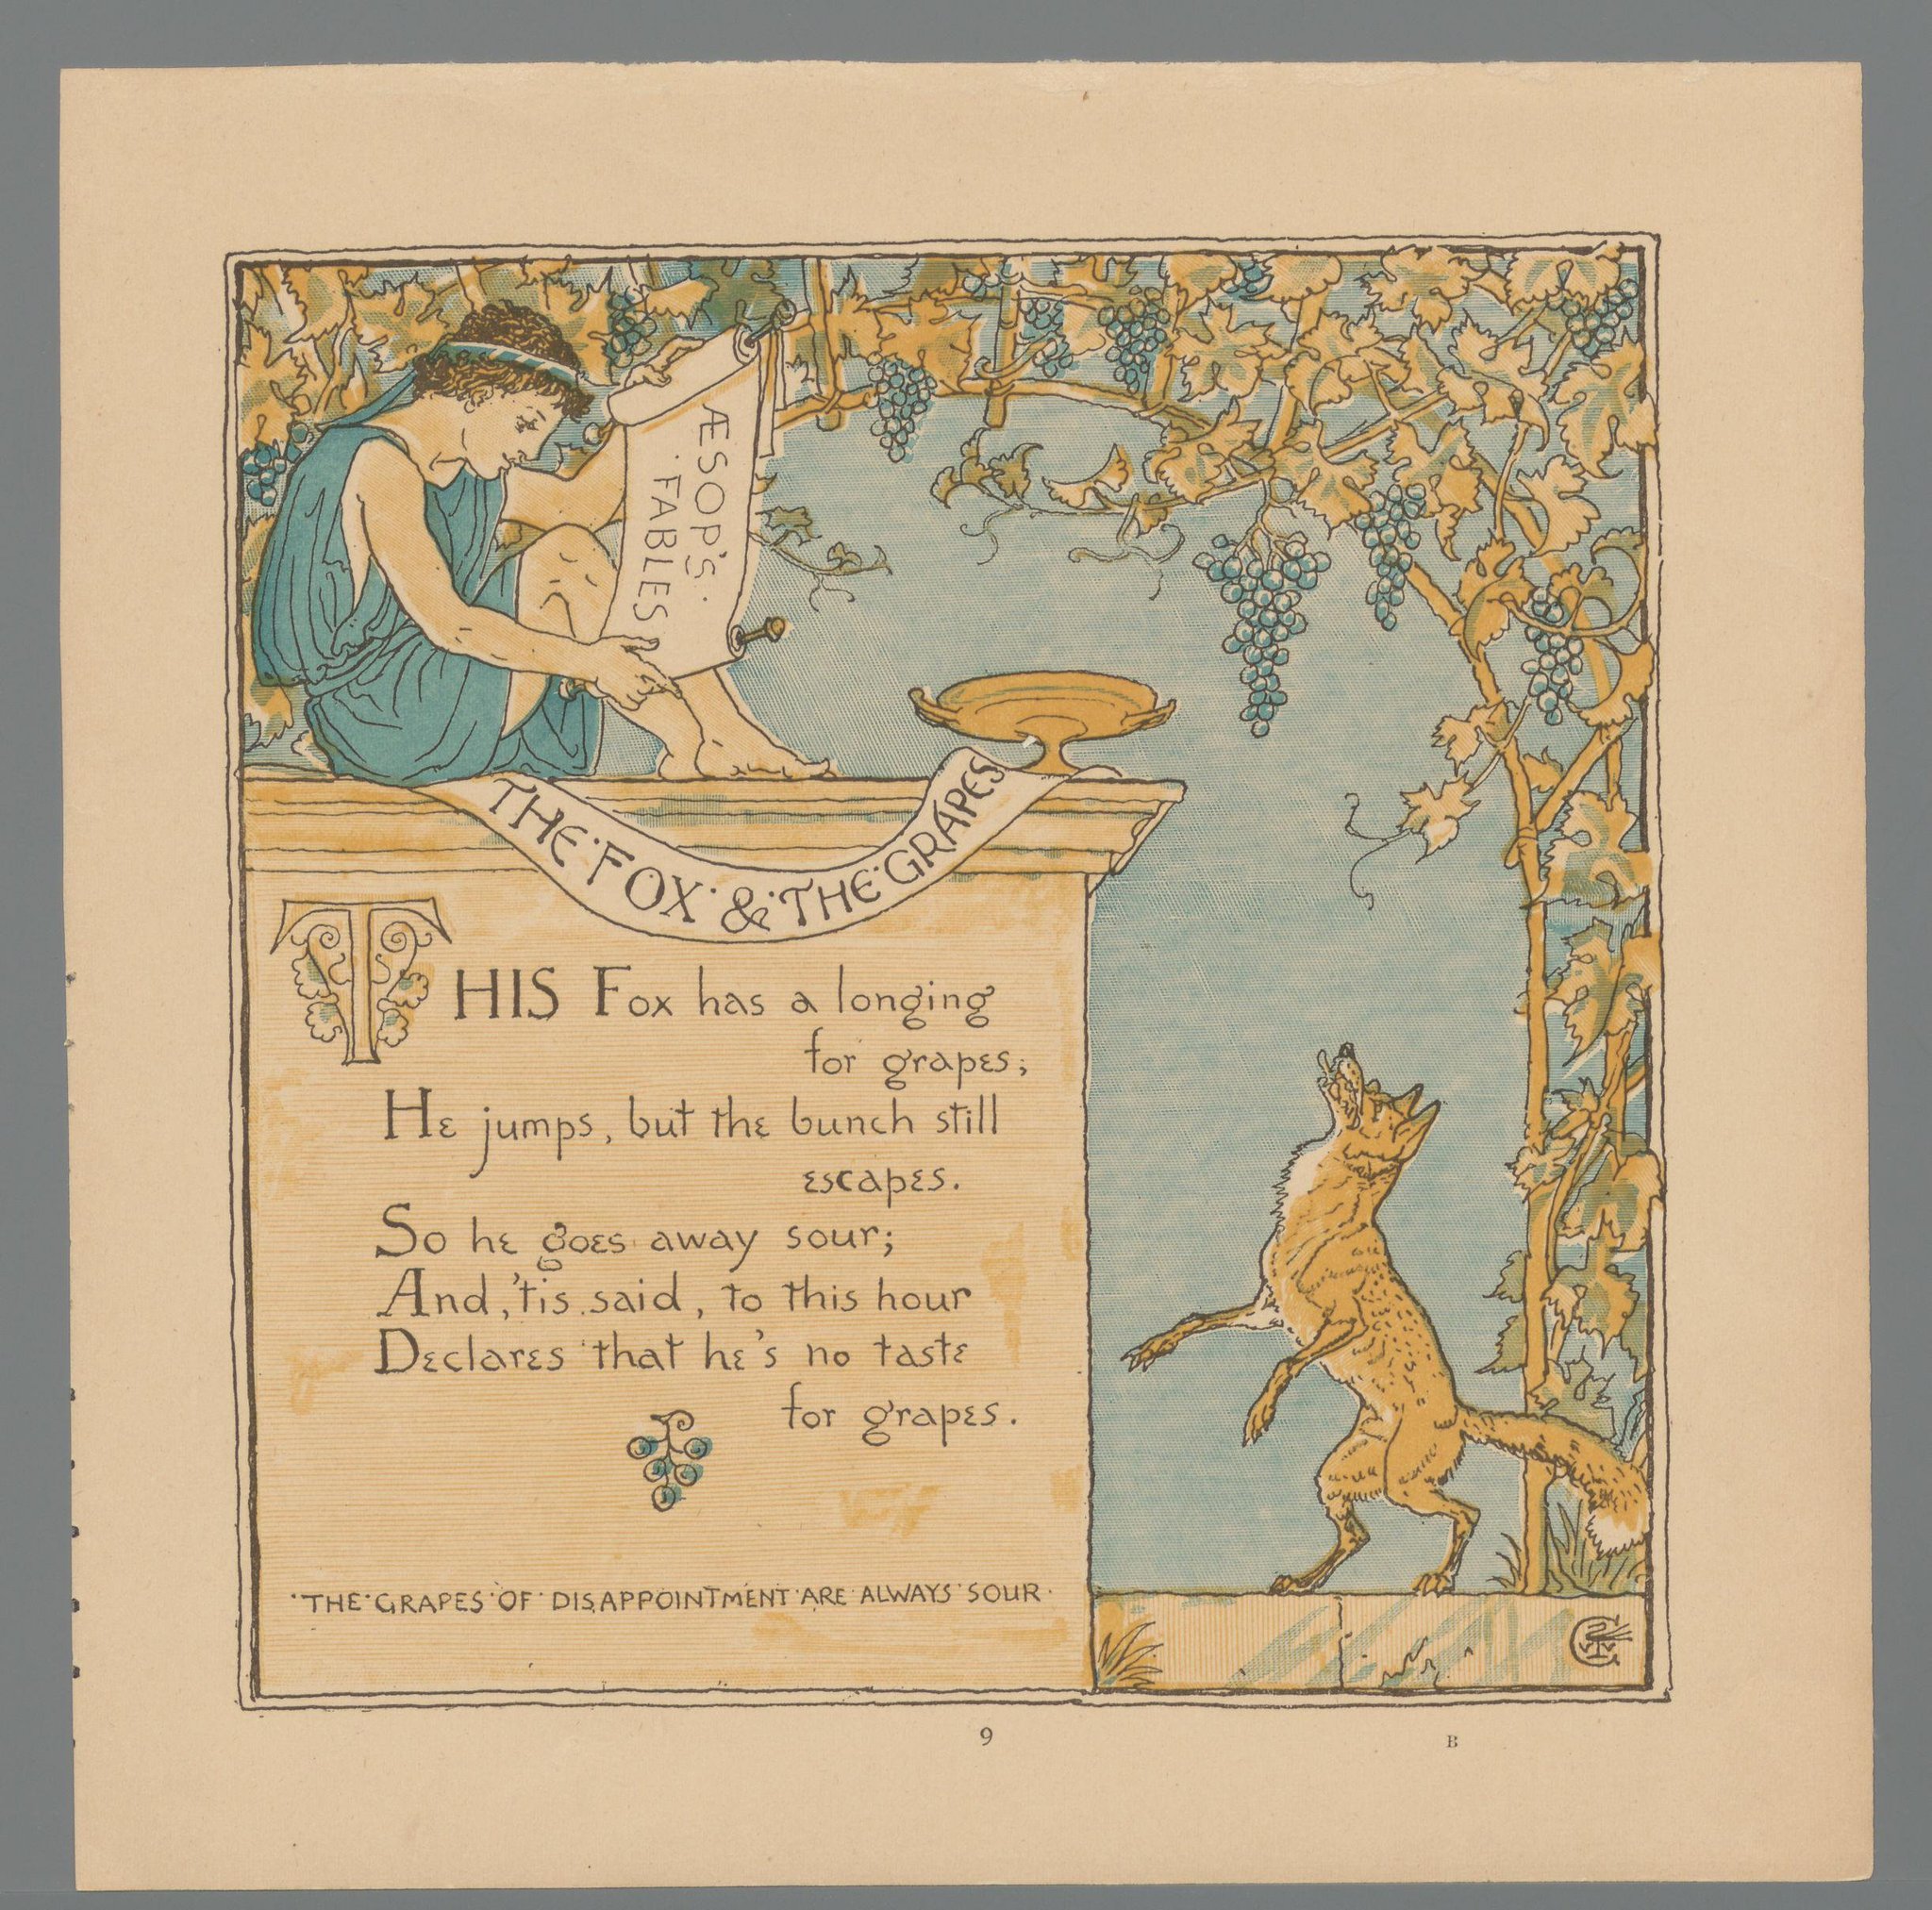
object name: book illustration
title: Man en vos onder druivenranken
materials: paper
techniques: wood engraving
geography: london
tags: vine, adult man, beasts of prey, predatory animals: fox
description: Prent uit: The baby's own Aesop being the fables condensed in rhyme. Londen: Routledge & Sons, 1887. Of een latere uitgave.